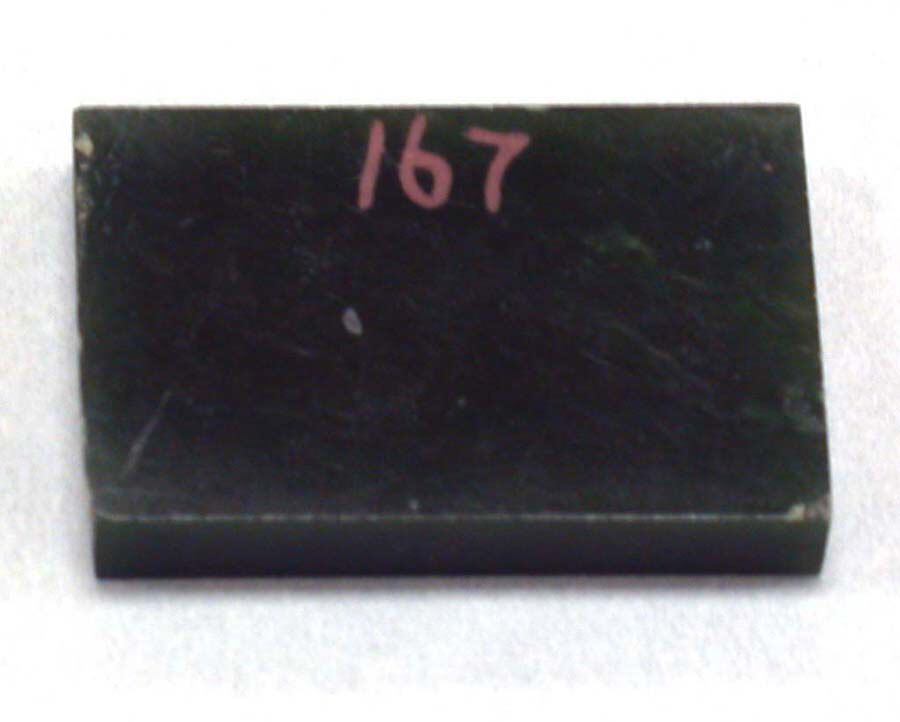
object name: fragment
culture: new zealander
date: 1902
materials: jade